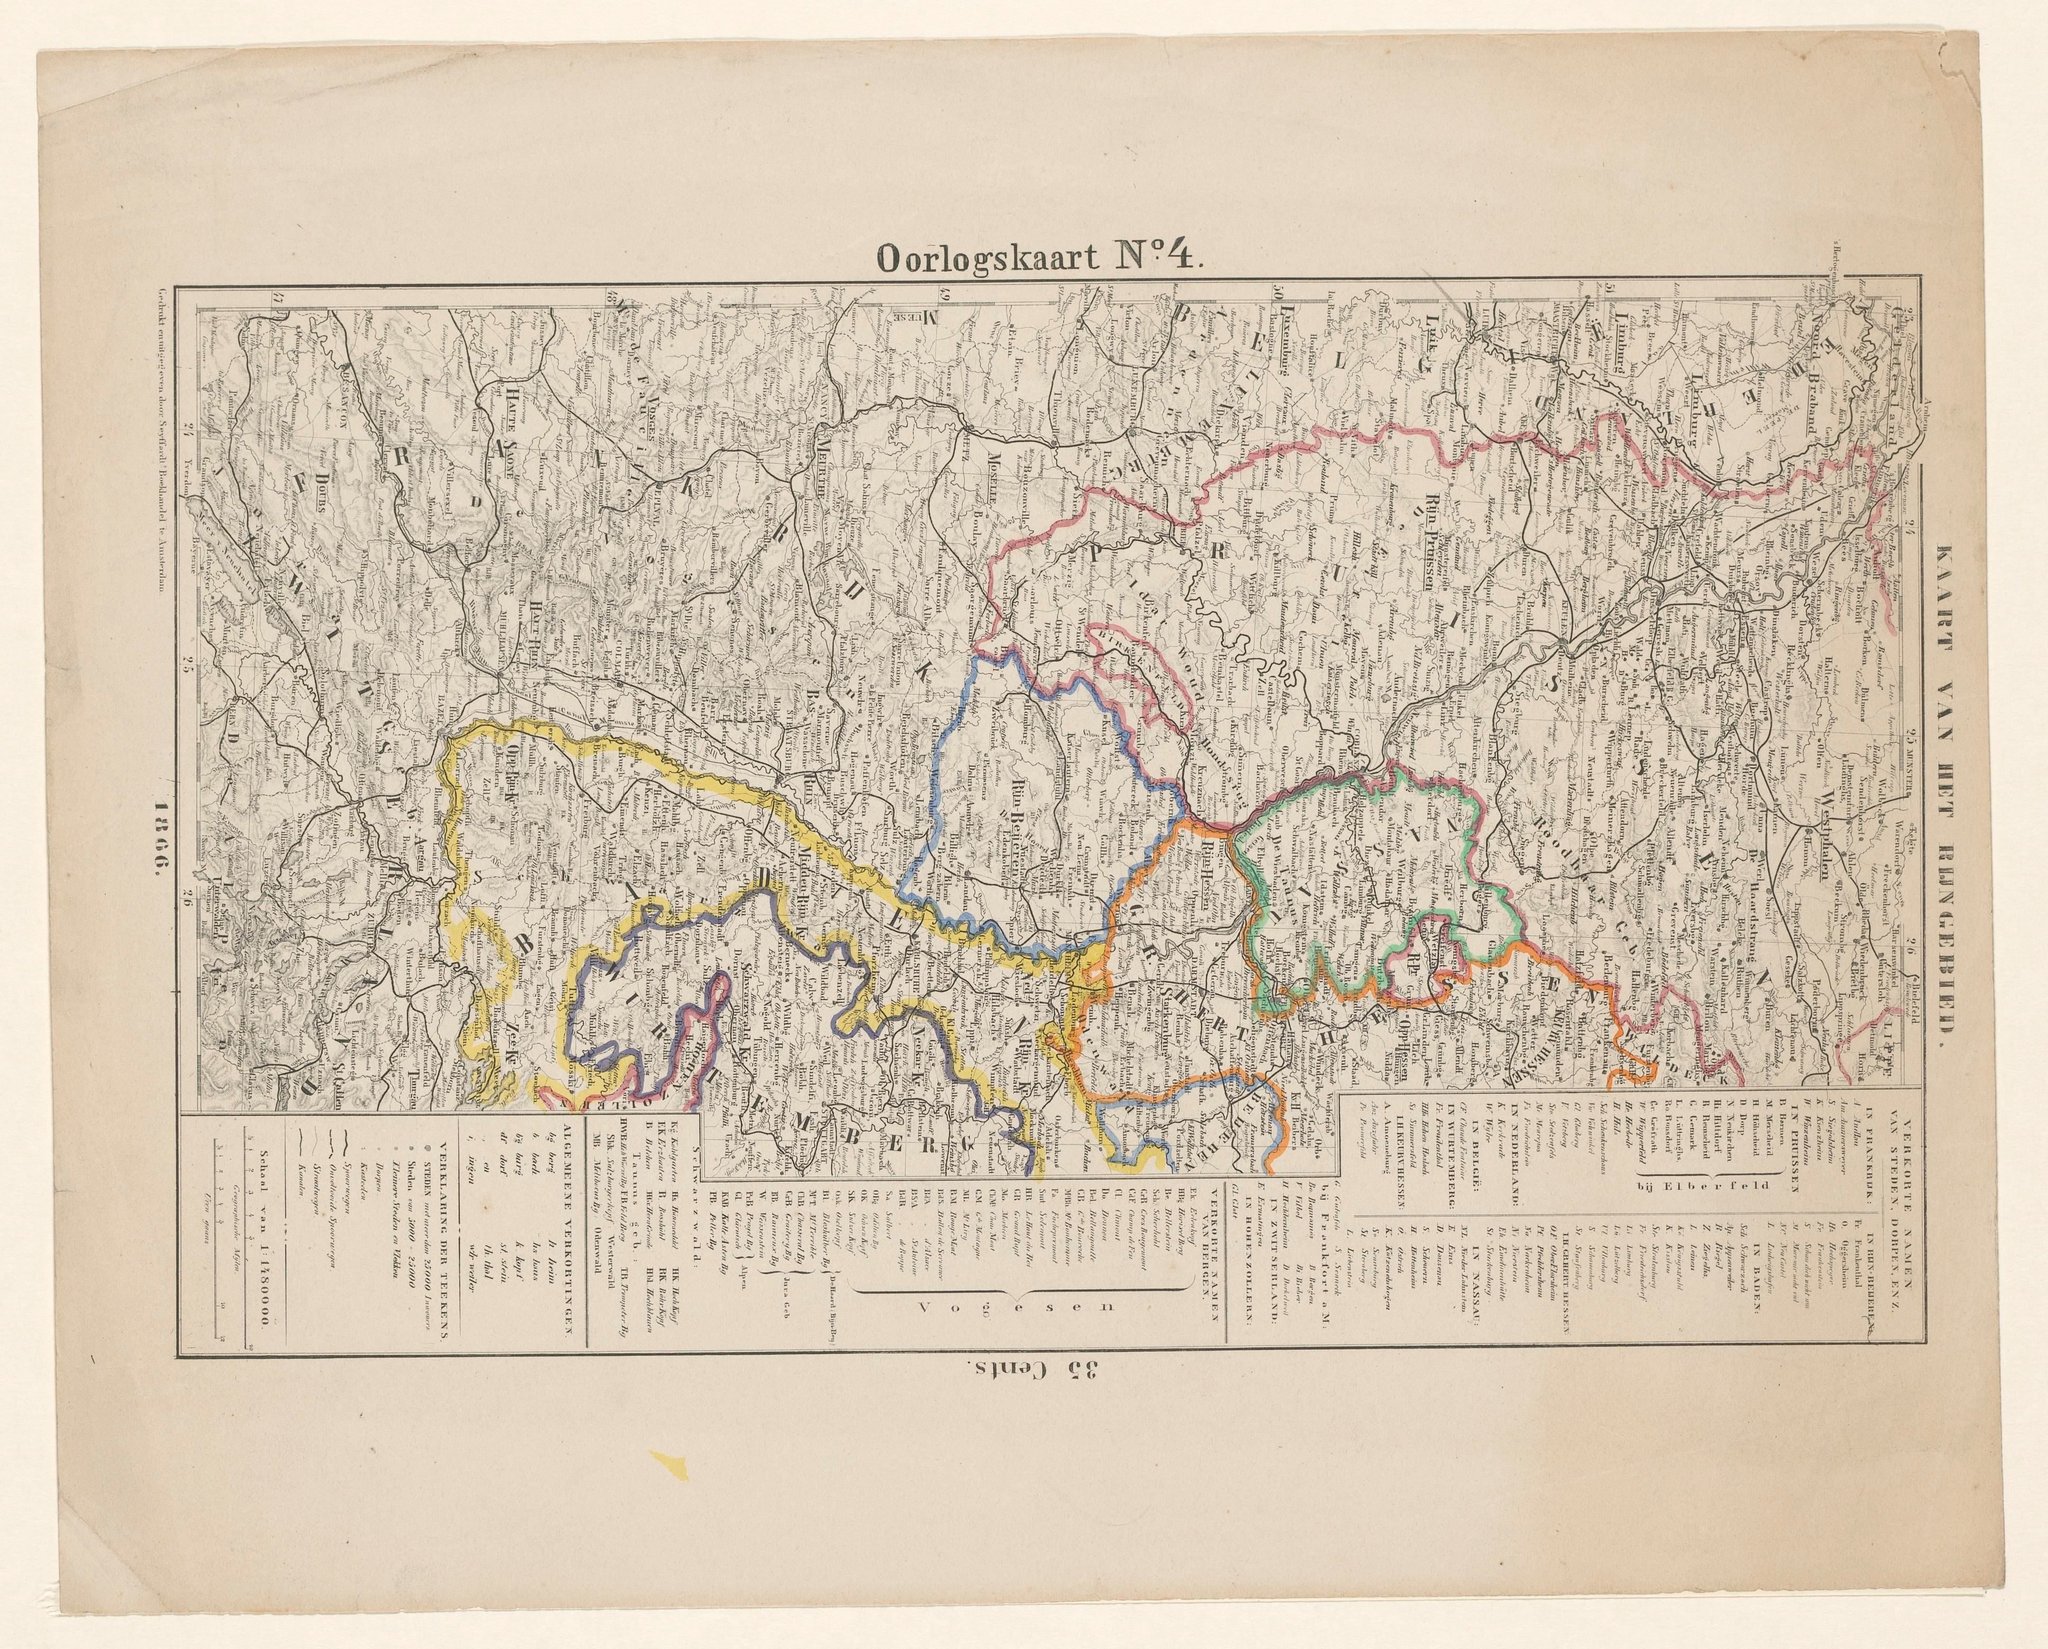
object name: map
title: Kaart van het Rijngebied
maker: Anonymous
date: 1866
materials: paper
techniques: lithograph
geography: amsterdam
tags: maps of separate countries or regions, austria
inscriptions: date